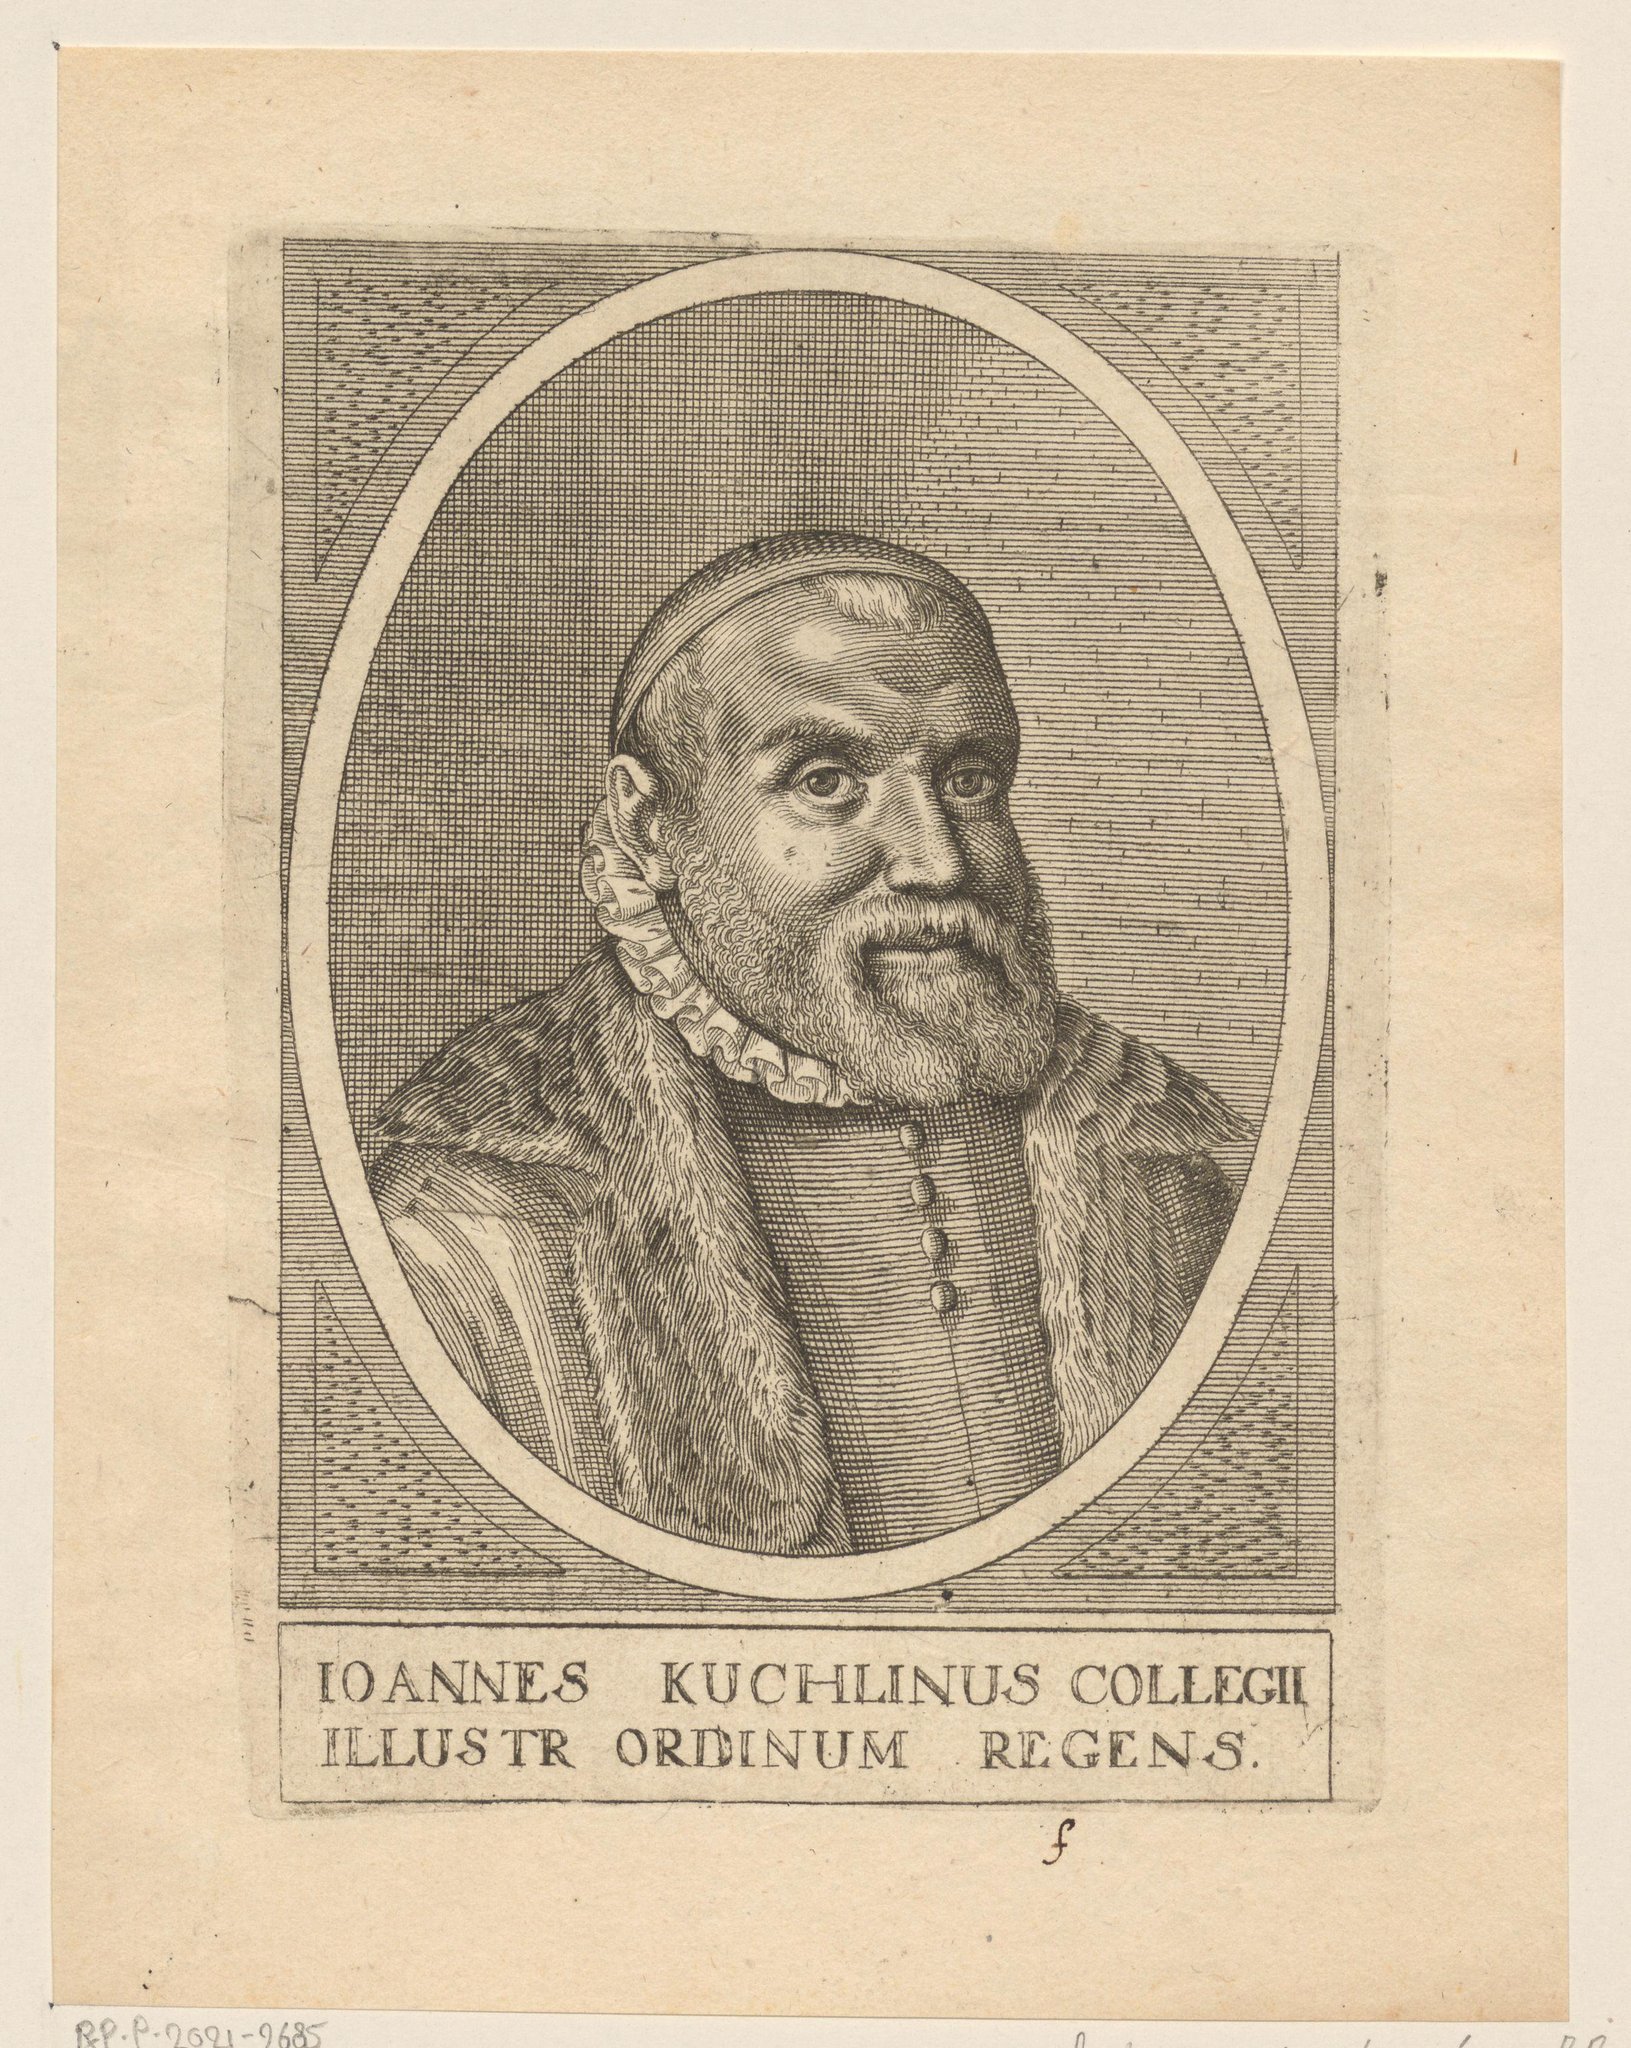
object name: print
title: Portret van Johannes Cuchlinus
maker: Anonymous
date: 1600-1649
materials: paper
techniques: engraving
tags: leiden, historical persons